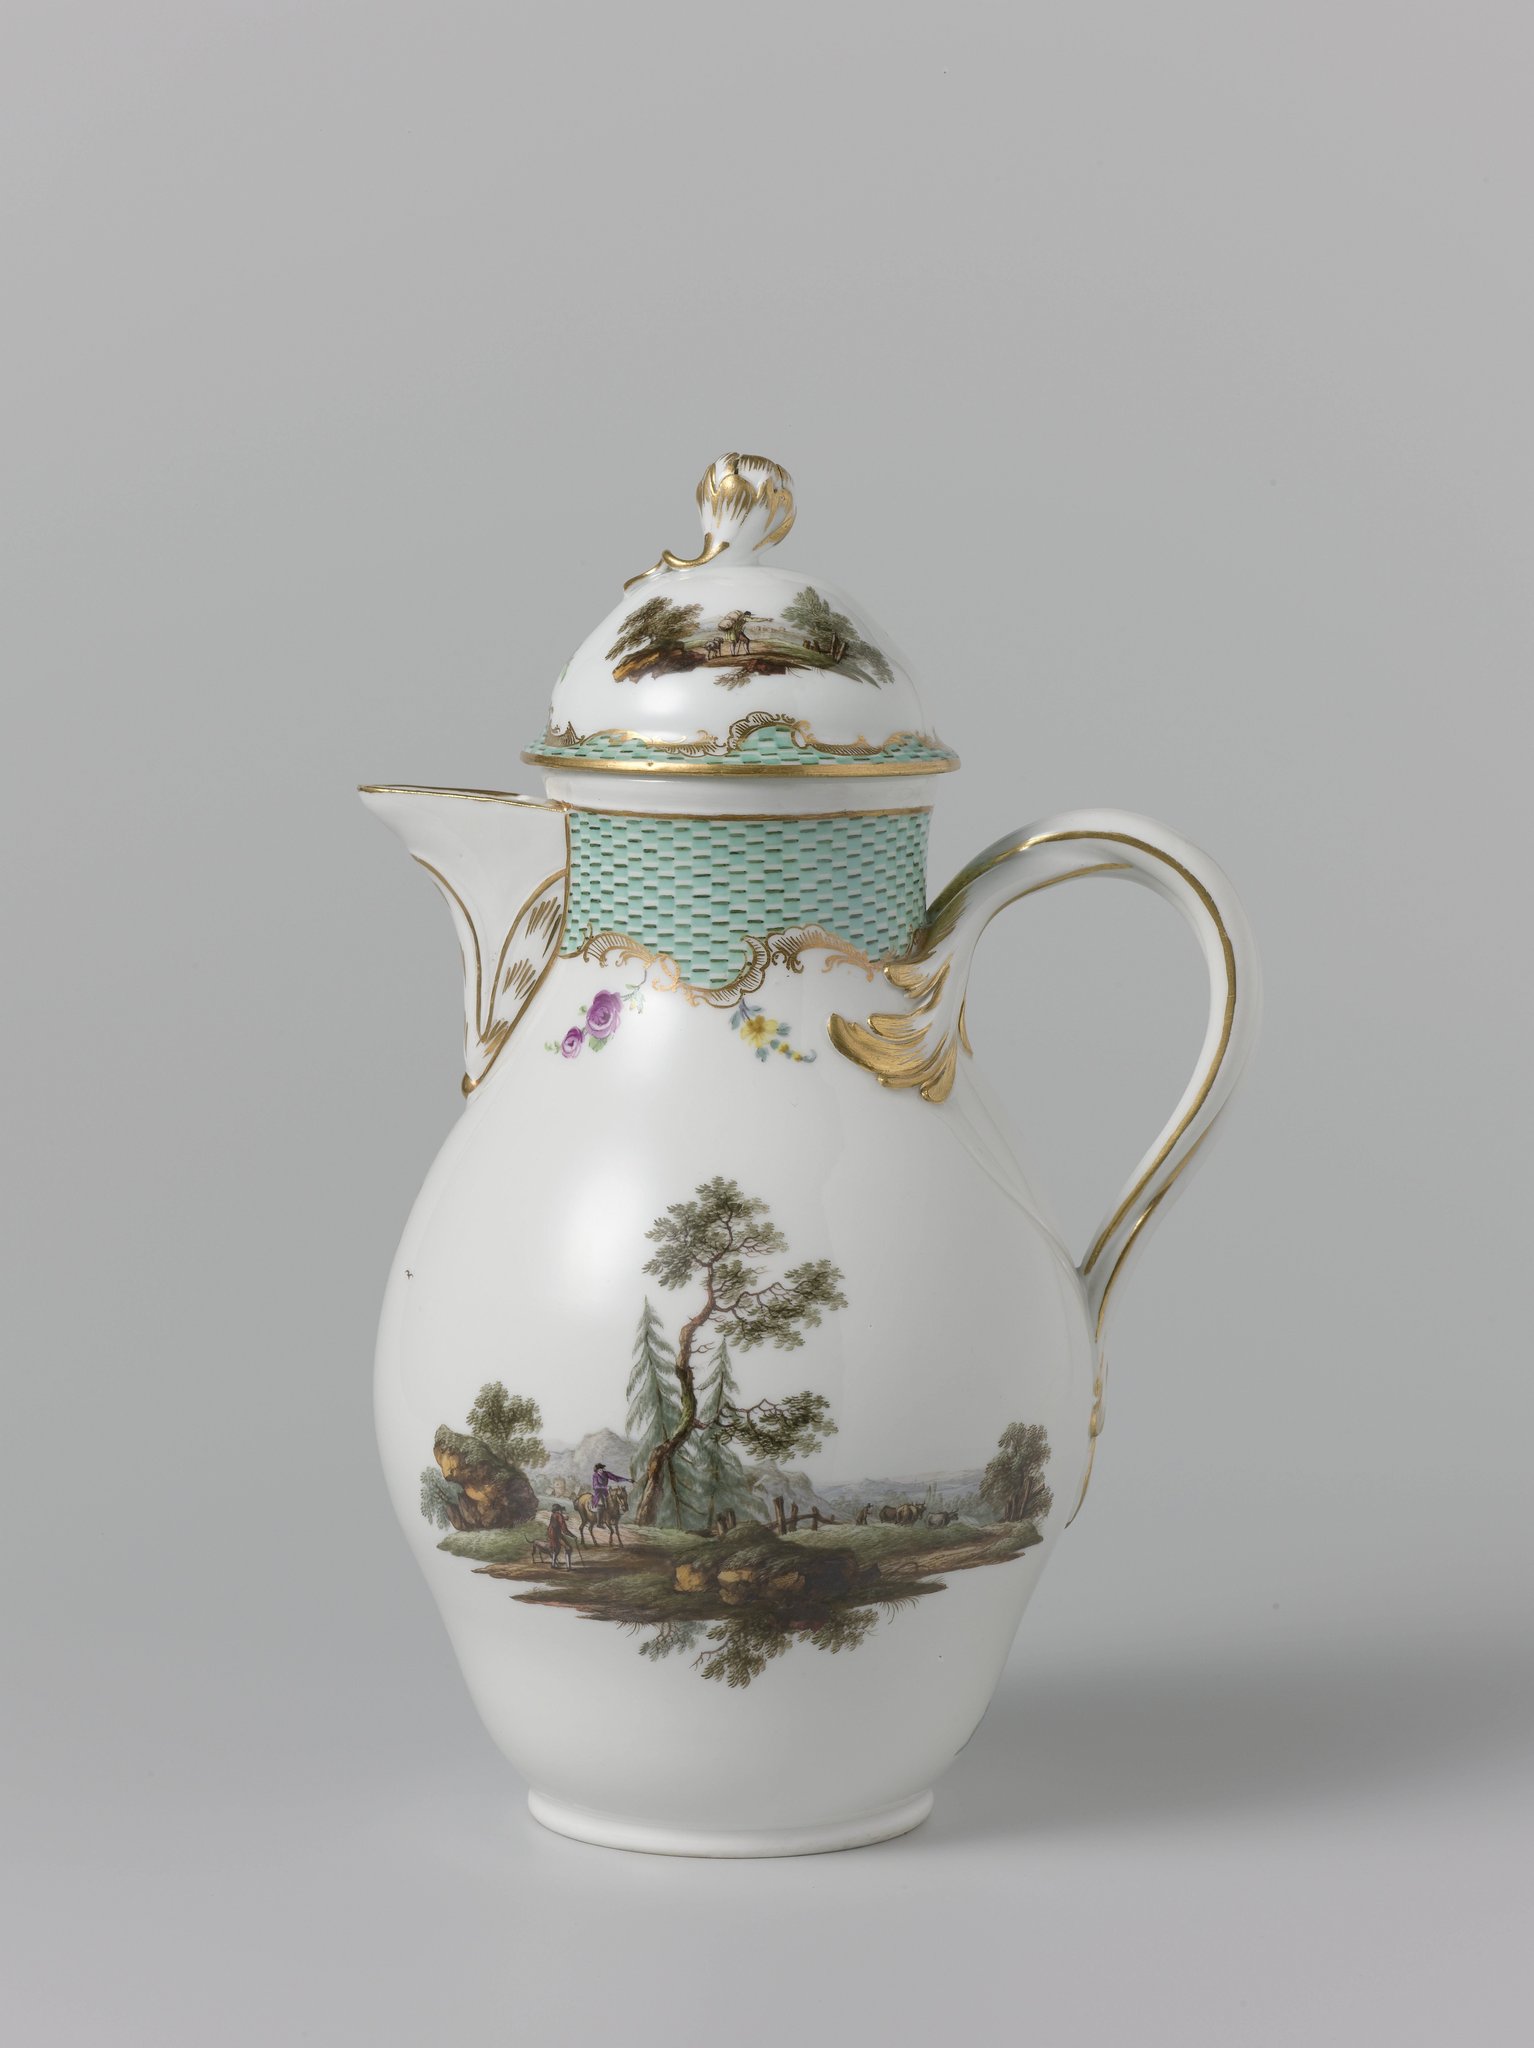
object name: eating drinking utensil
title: Koffiepot met deksel, veelkleurig beschilderd met landschappen met figuren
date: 1777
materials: porcelain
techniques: painted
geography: meissen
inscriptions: factory mark, mold mark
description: Peervormige koffiepot van beschilderd porselein. De pot heeft een C-vormig oor, een sneb en een gewelfd deksel met een knop in de vorm van een bloemknop aan een tak. De pot is beschilderd met landschappen waarin figuren en langs de rand een brede strook groen vlechtwerk. De pot is gemerkt.